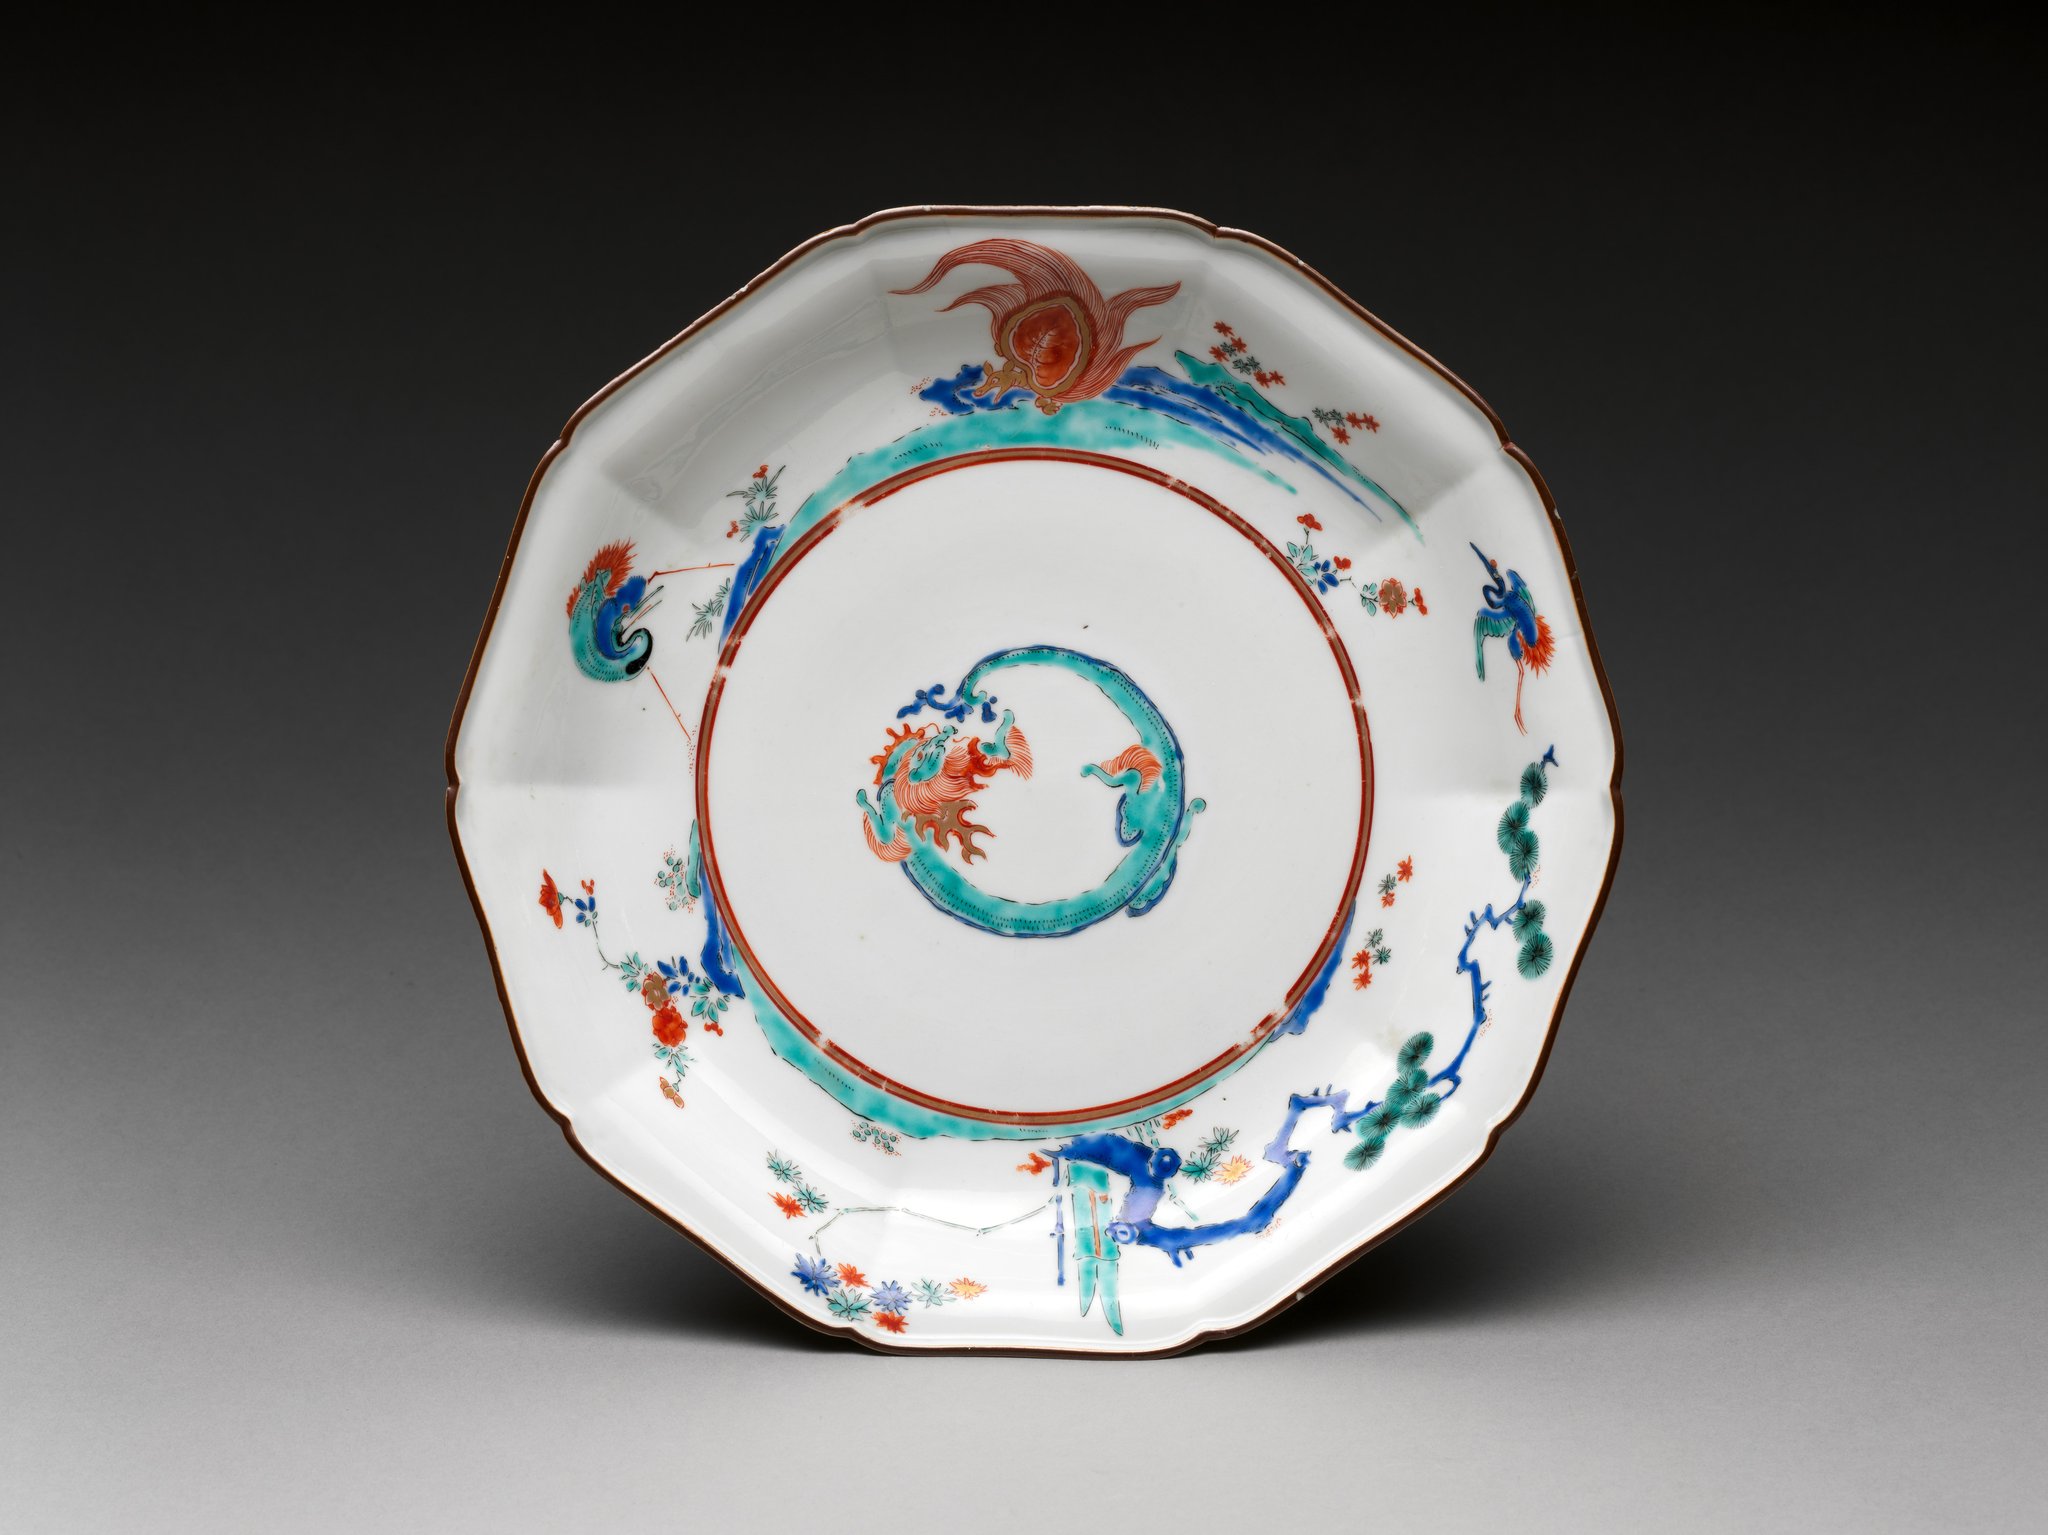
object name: dish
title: Dish with dragon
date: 1680-1700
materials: enamel, glaze, hard paste porcelain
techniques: painting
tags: dragons